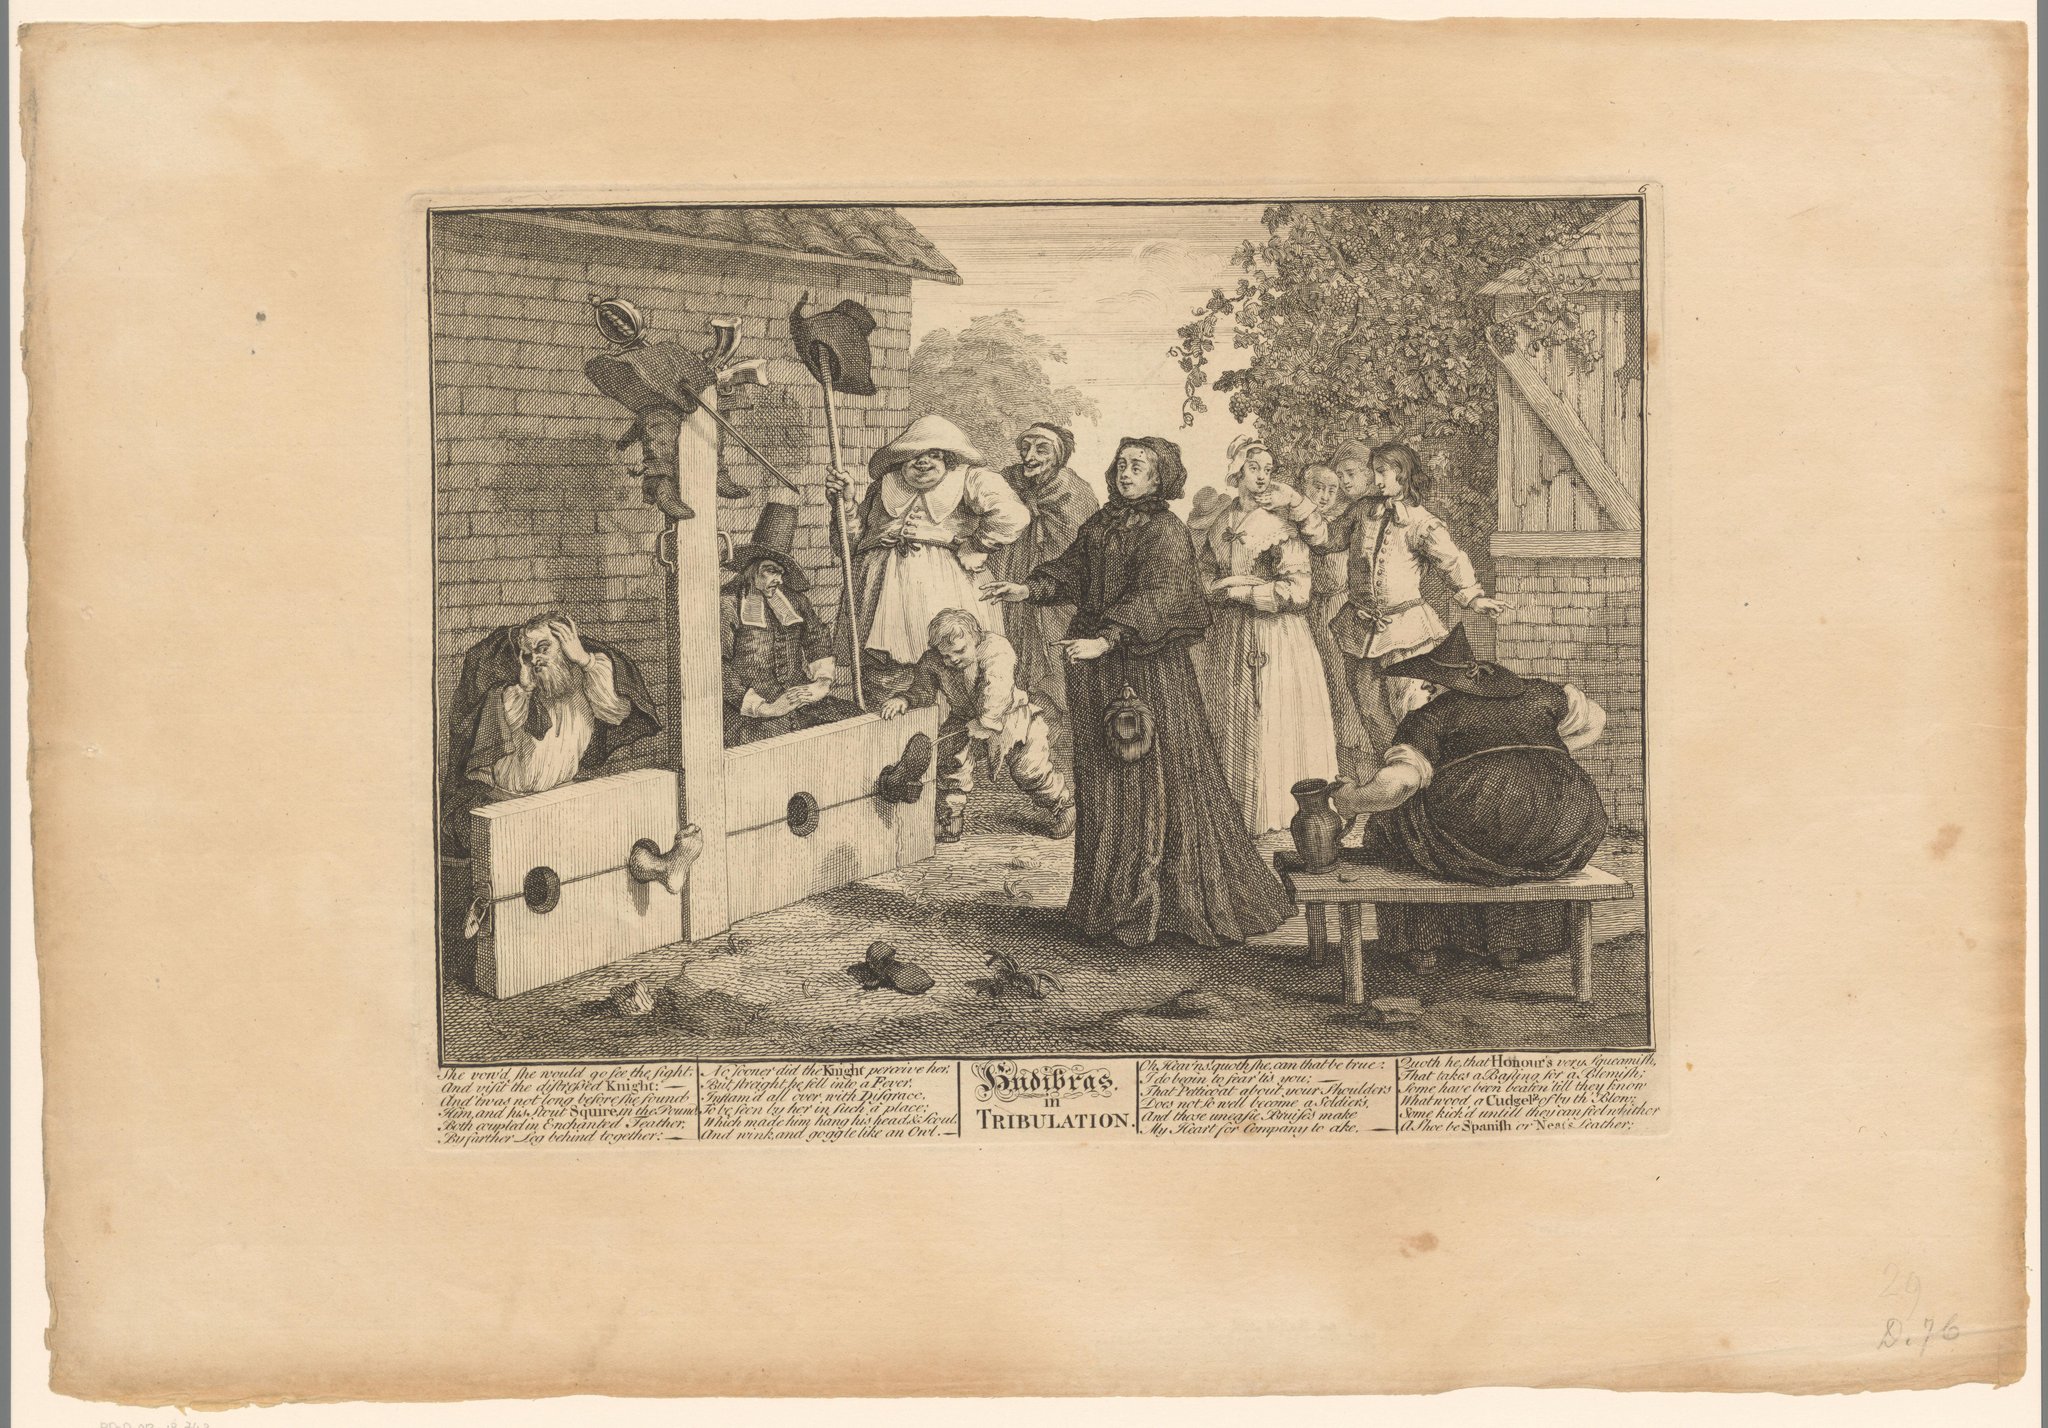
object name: print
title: Hudibras in Tribulation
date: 1725-1735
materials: paper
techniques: engraving, etching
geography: london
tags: in the pillory, in the stocks, political caricatures and satires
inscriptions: collector's mark: Lugt 2228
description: De prenten in deze serie zijn gebaseerd op de satirische polemiek: Butler, Samuel. Hudibras. Londen: s.n., 1663-1678.